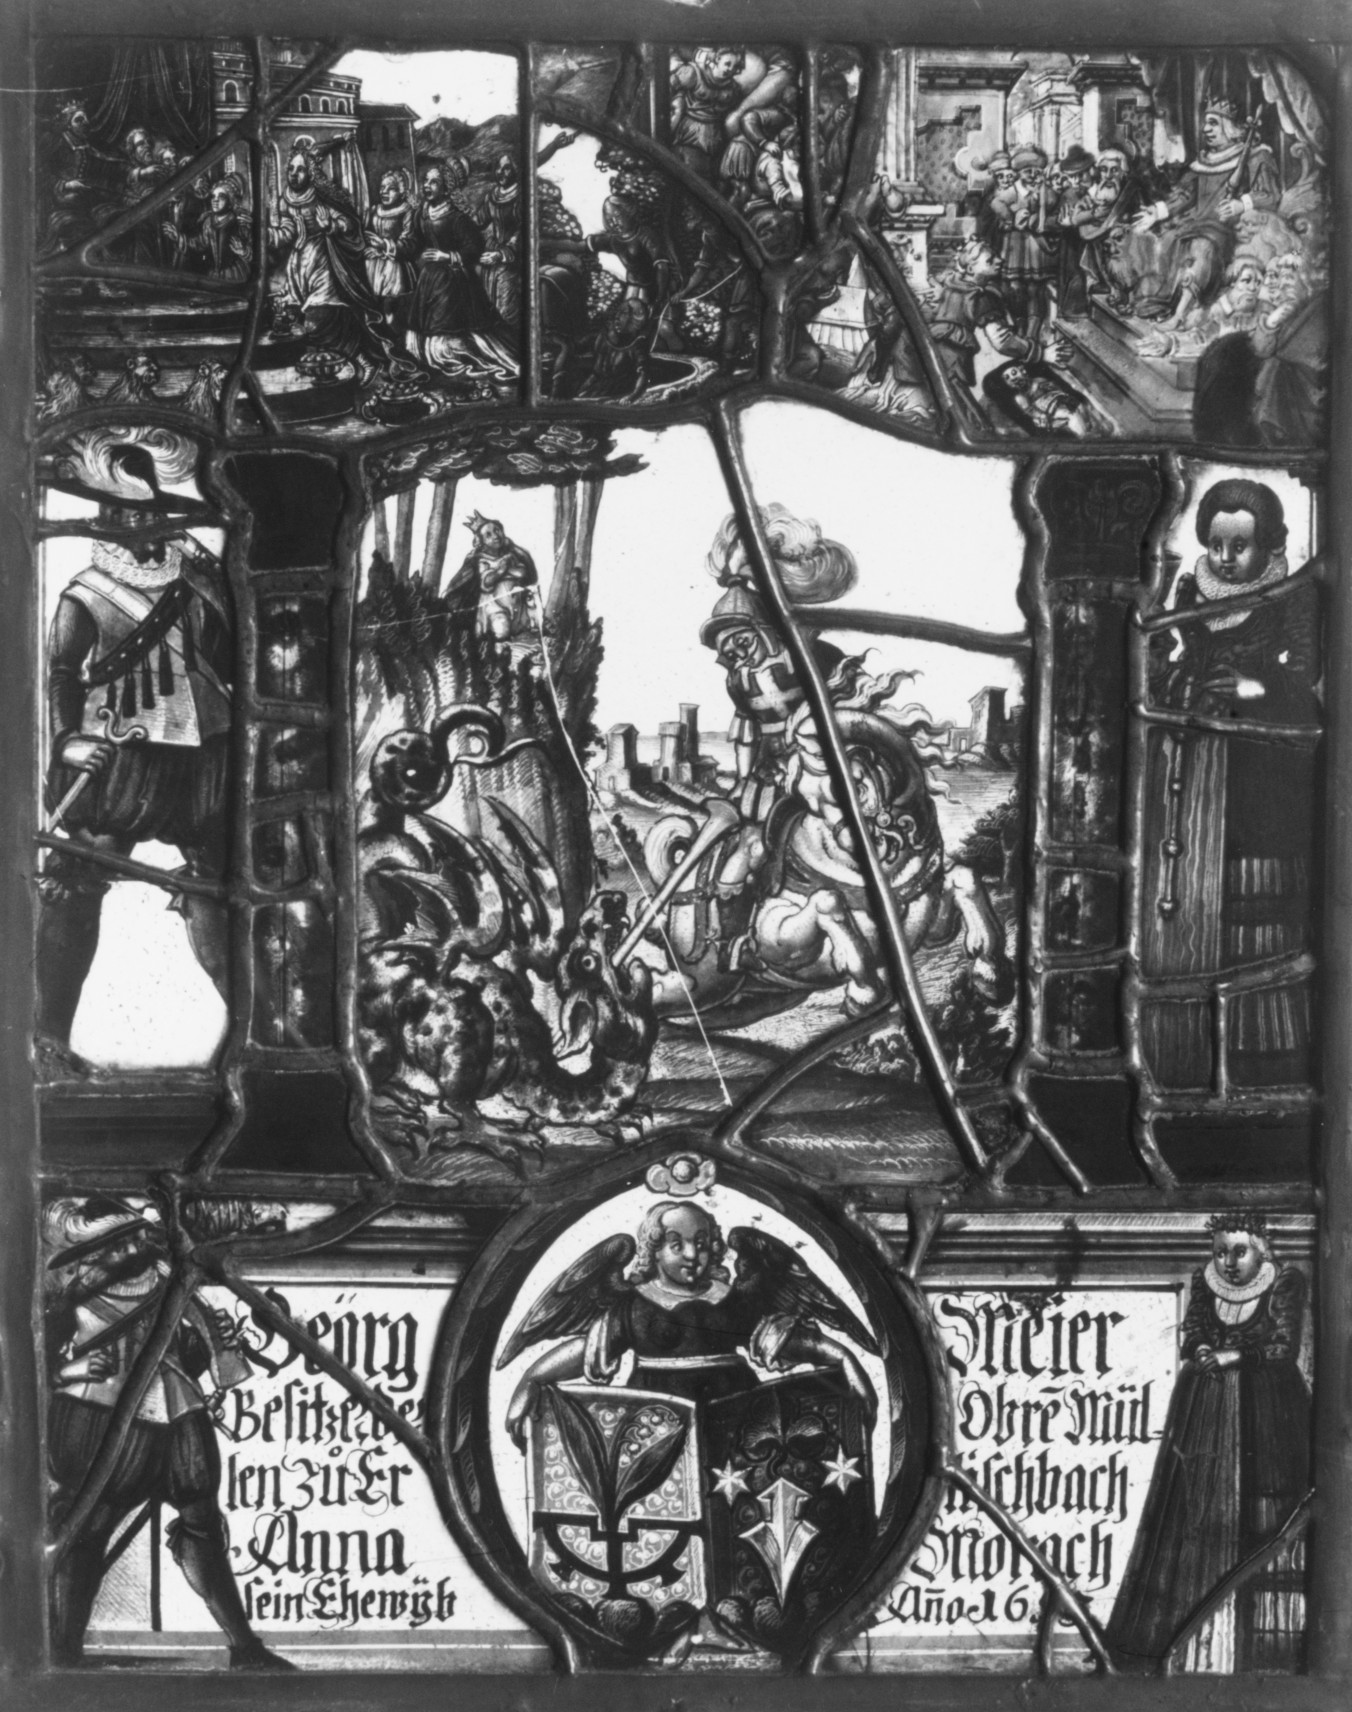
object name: panel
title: Saint George and the Dragon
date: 1653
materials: glass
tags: men,women,dragons,saint george,death